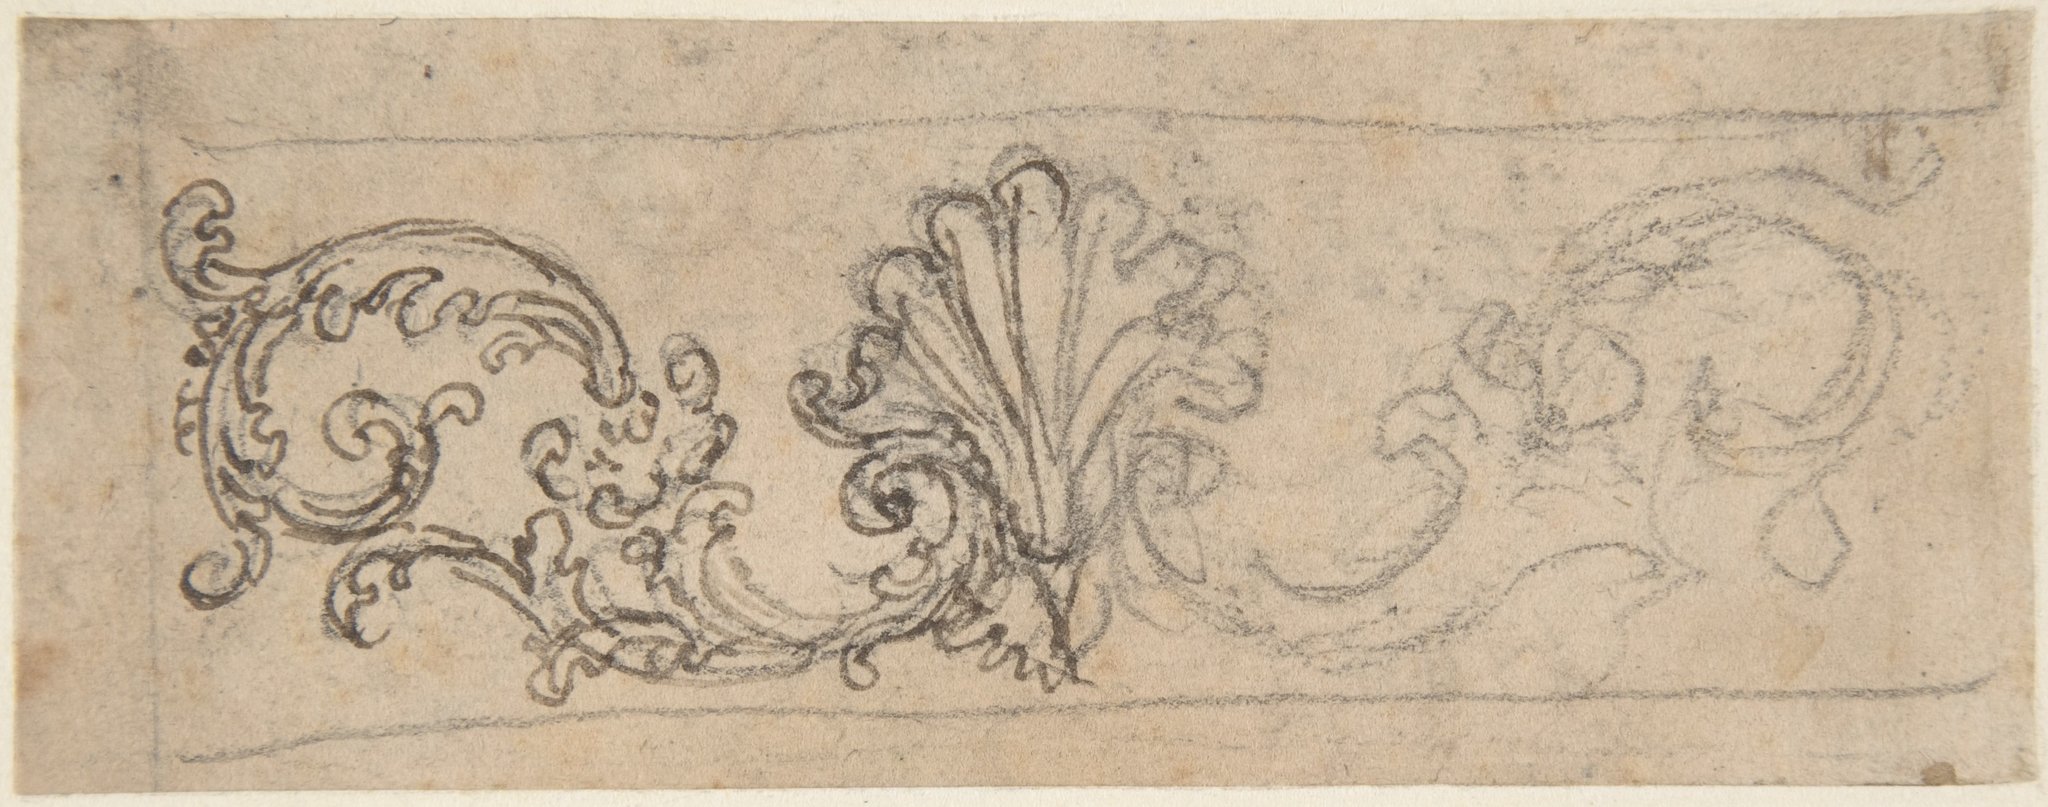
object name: drawing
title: Design for a Frieze Decorated With a Palmette and Tendrils (recto); Two Designs for a Rosette (verso)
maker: giovanni battista foggini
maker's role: artist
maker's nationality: italian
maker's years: 1652-1725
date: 1672-1725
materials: chalk, ink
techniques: pen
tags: palmettes,flowers